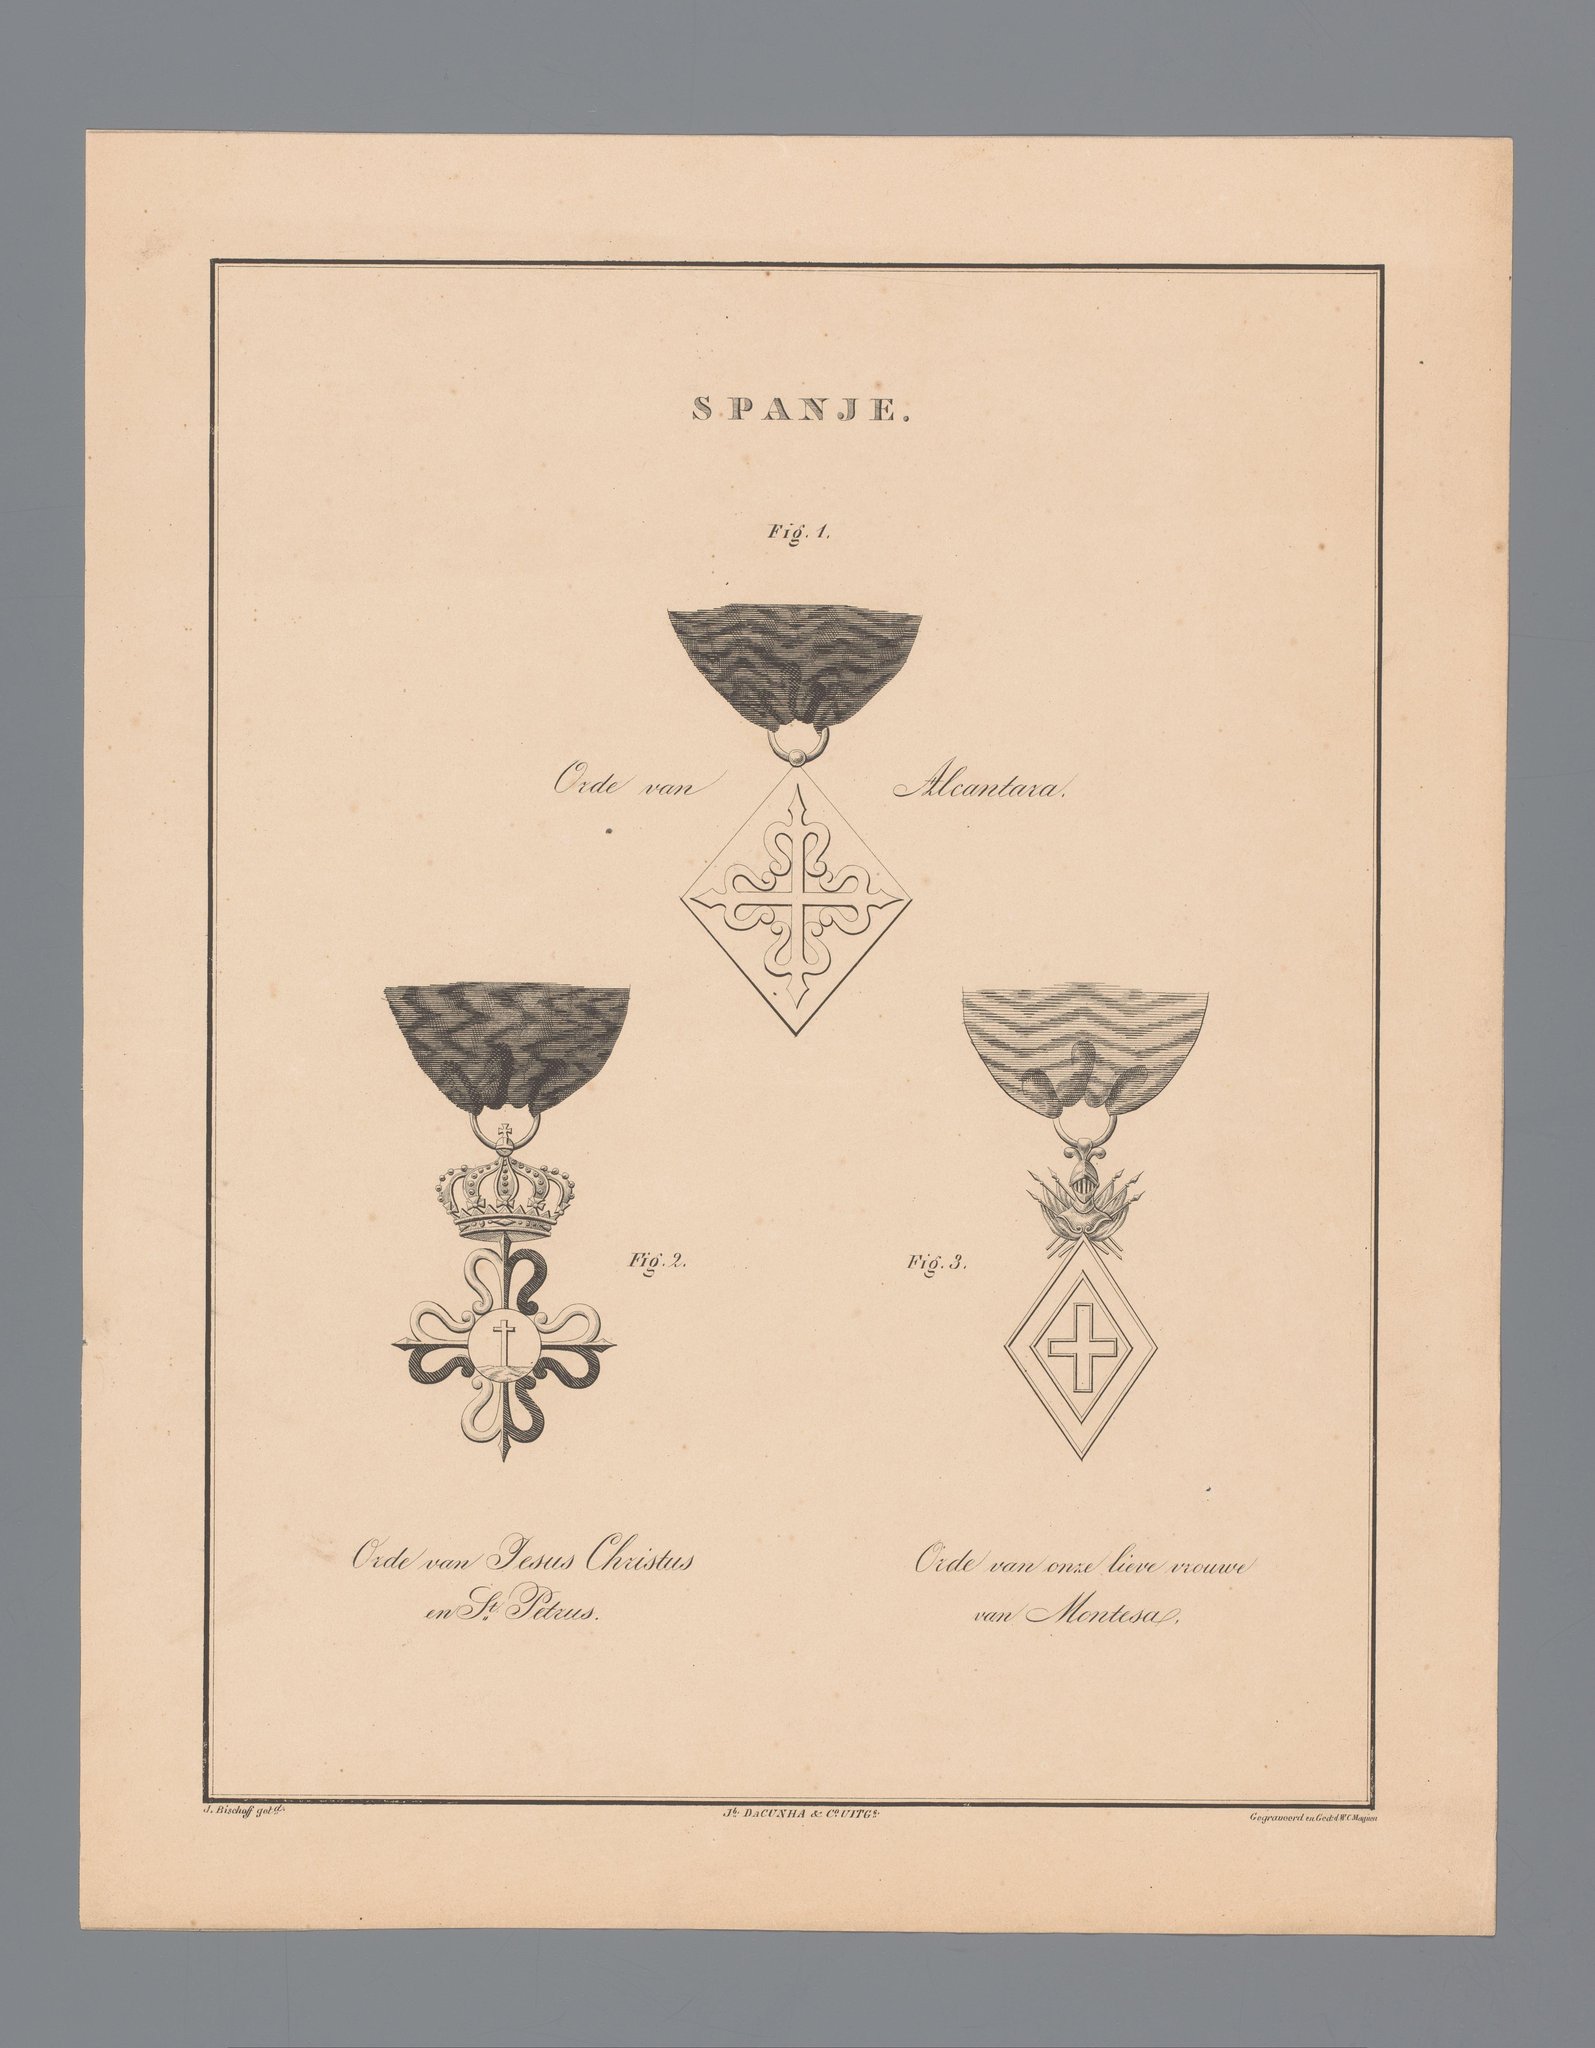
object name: print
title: Geschiedkundige beschrijving der oudere en nieuwere, thans bestaande ridderorden, zoo in als buiten Europa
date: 1843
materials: paper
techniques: lithograph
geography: amsterdam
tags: knighthood order, spain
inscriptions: collector's mark: Lugt 2228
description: Deze prent werd uitgegeven in: G.L. de Rochemont en J. Bischoff, Geschiedkundige beschrijving der oudere en nieuwere, thans bestaande ridderorden, zoo in als buiten Europa (...) Amsterdam, Jb. da Cunha & Co: 1843.